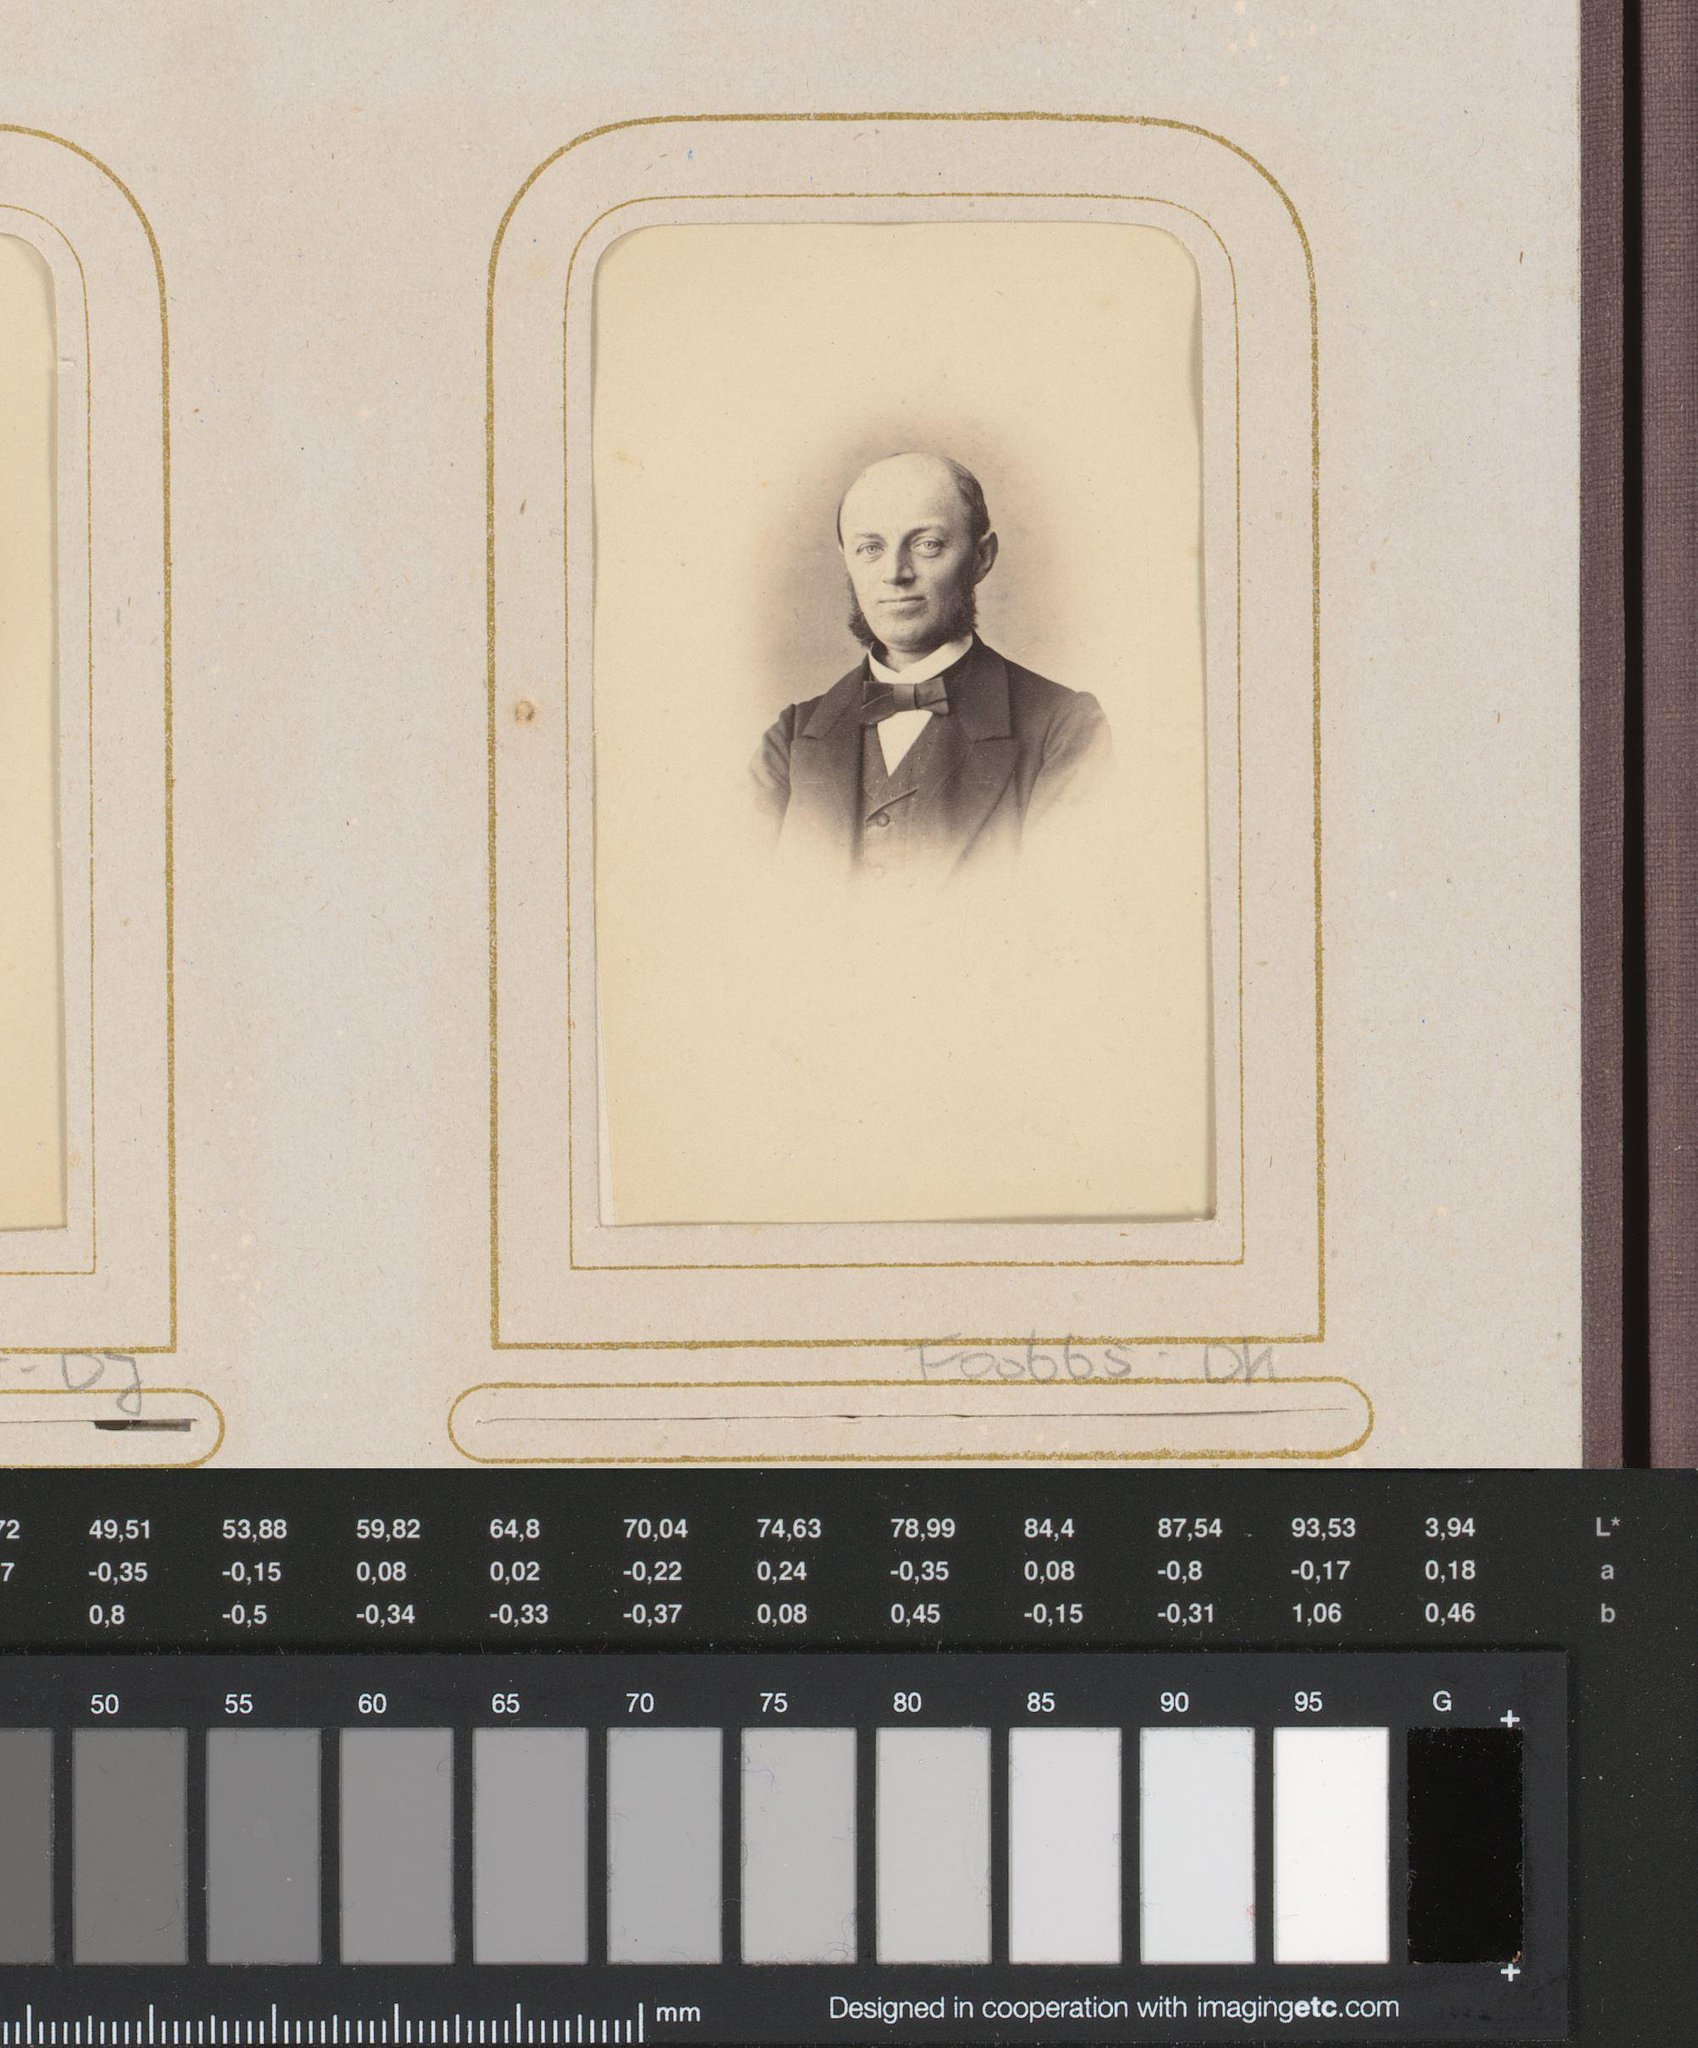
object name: album leaf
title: Portret van een man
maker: Anonymous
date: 1855-1880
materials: cardboard, photographic support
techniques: albumen print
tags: historical persons